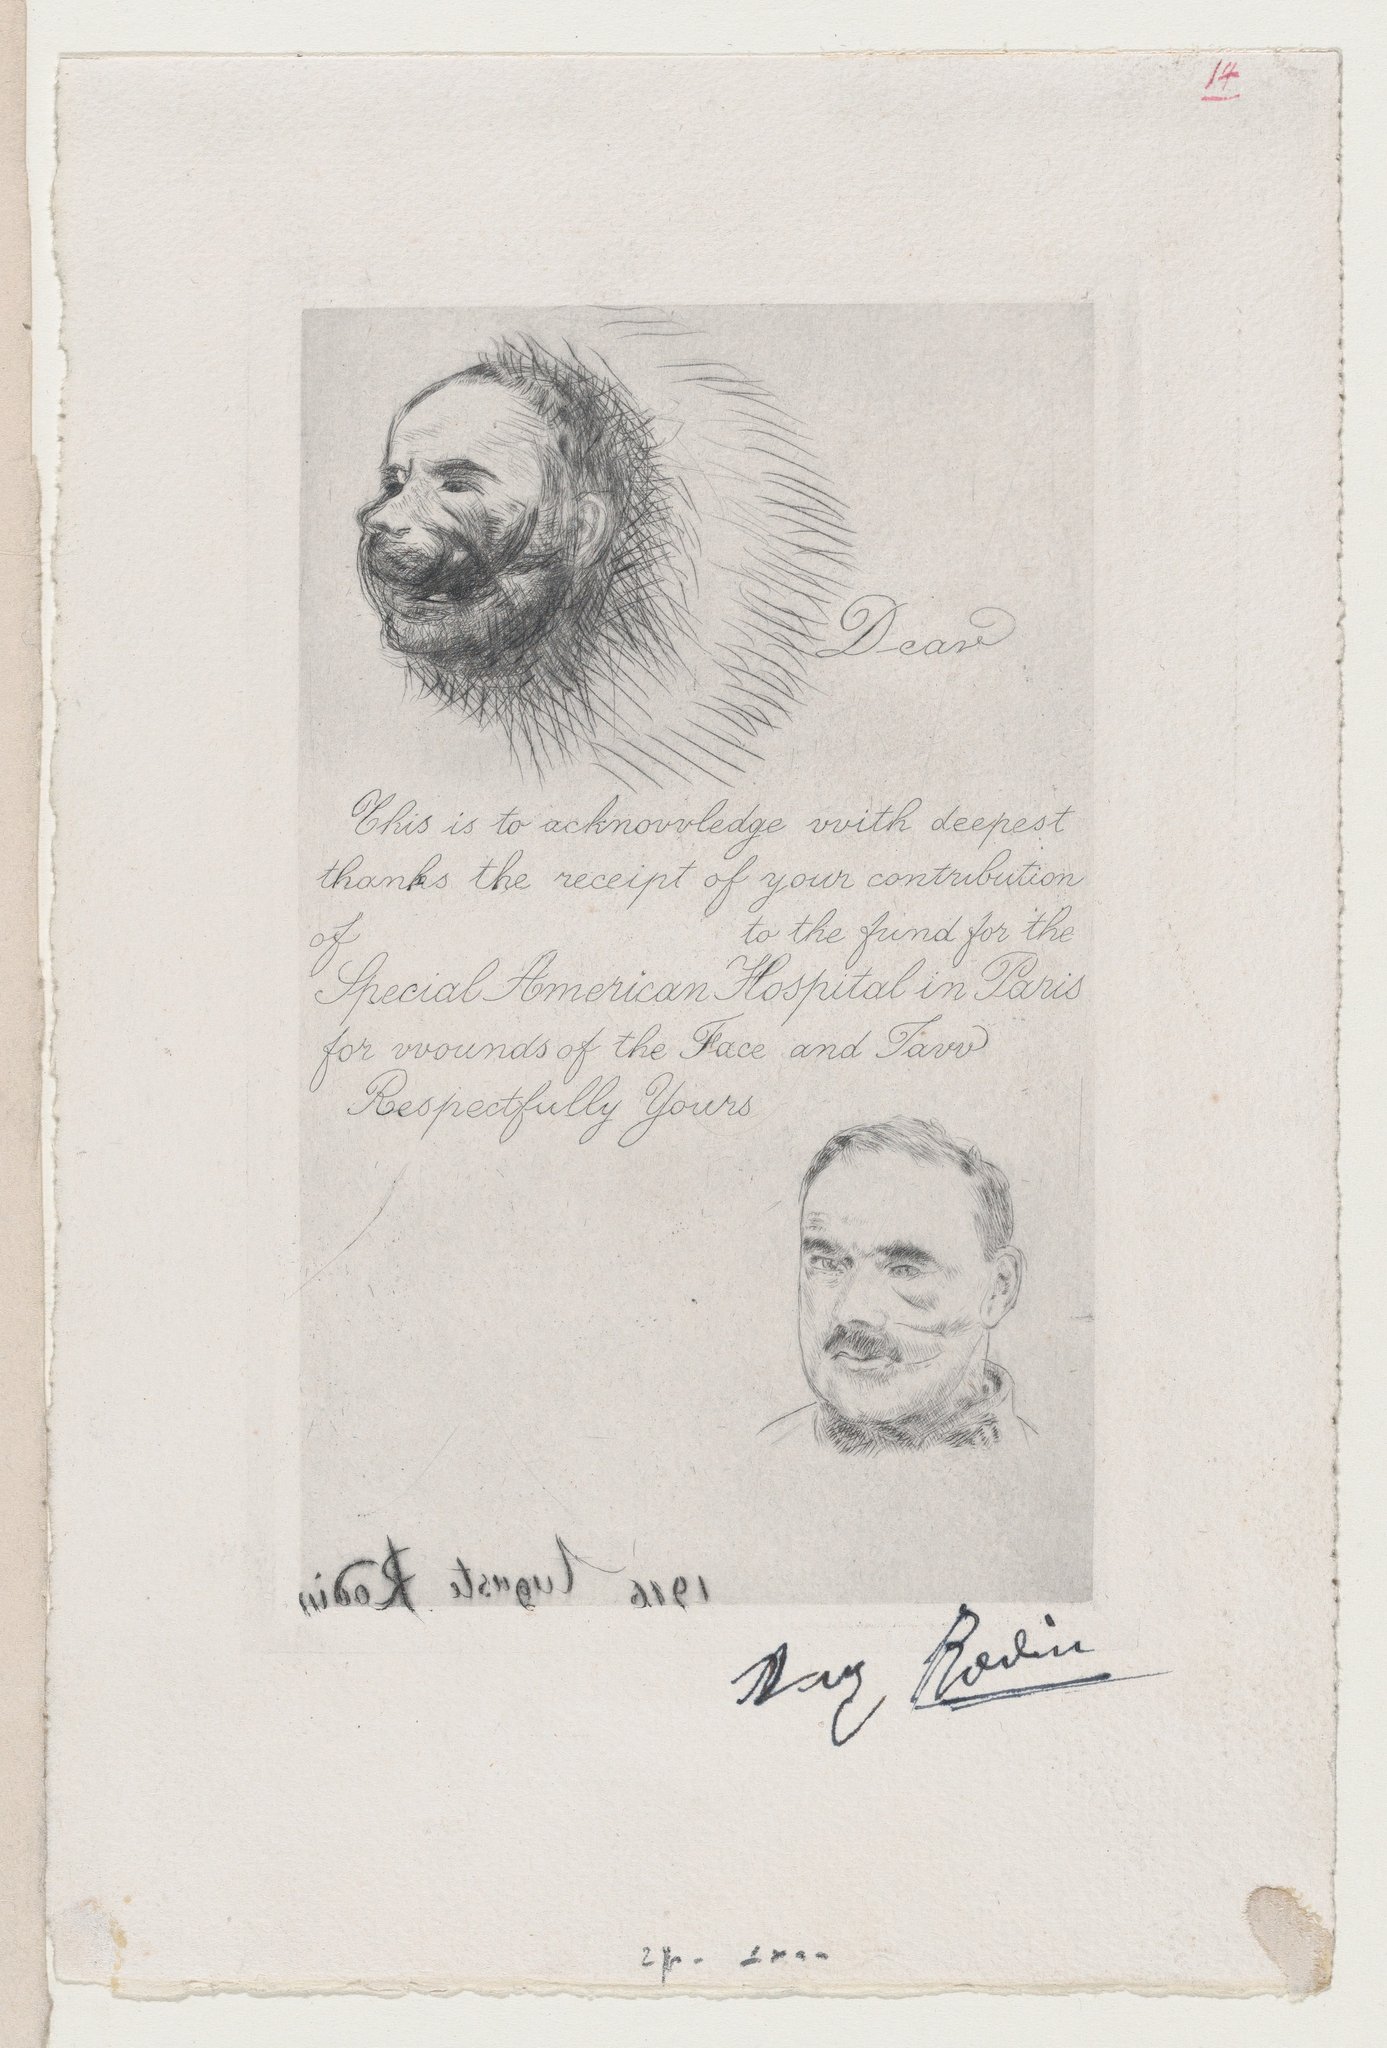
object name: print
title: Contribution Receipt of the Special American Hospital in Paris for Wounds of the Face and Jaw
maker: auguste rodin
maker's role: artist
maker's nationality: french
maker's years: 1840-1917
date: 1916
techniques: drypoint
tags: heads